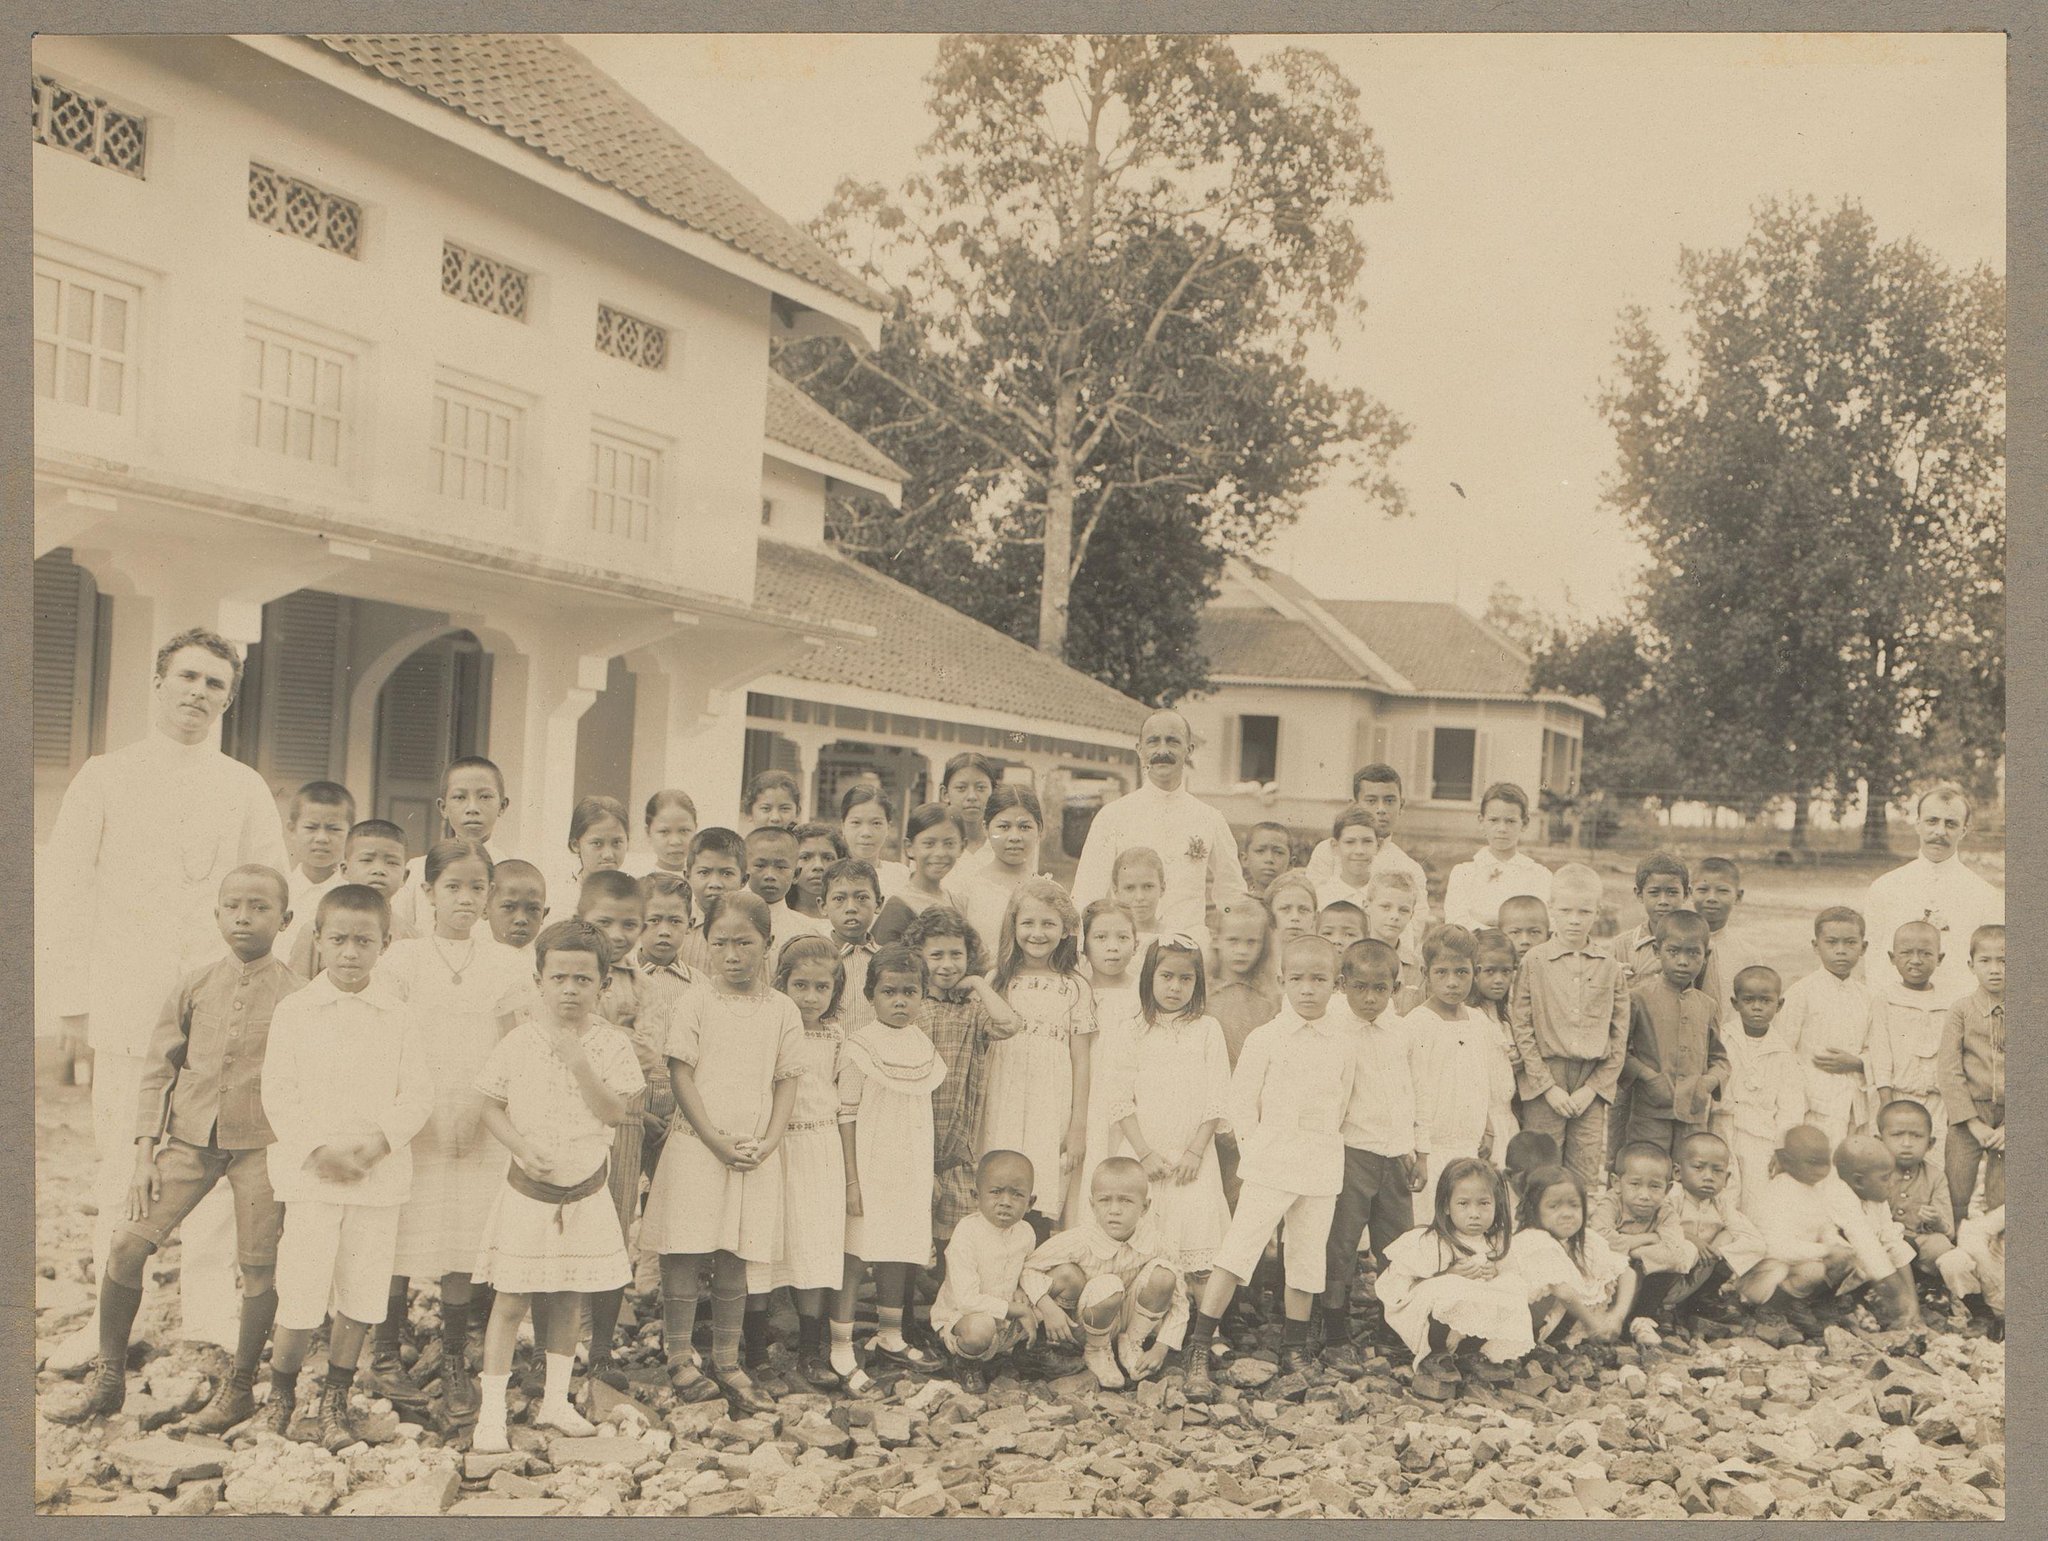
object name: photograph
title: Pangkalpinang. Hollandsche school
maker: Anonymous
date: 1914-1919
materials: photographic support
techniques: gelatin silver print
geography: bangka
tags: robert julius boers, colonial system, mining, elementary school; class, form (+ teacher, professor), elementary school; class, form (+ pupil)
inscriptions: inscription: ‘Pangkalpinang. Hollandsche school’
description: Groepsfoto van de leerlingen en leerkrachten voor het gebouw van de Hollandse School van de Banka-tinwinning te Pangkalpinang. Onderdeel van het fotoalbum aangeboden aan Robert Julius Boers bij zijn vertrek naar Nederland in 1919 door het personeel van de Banka-tinwinning.